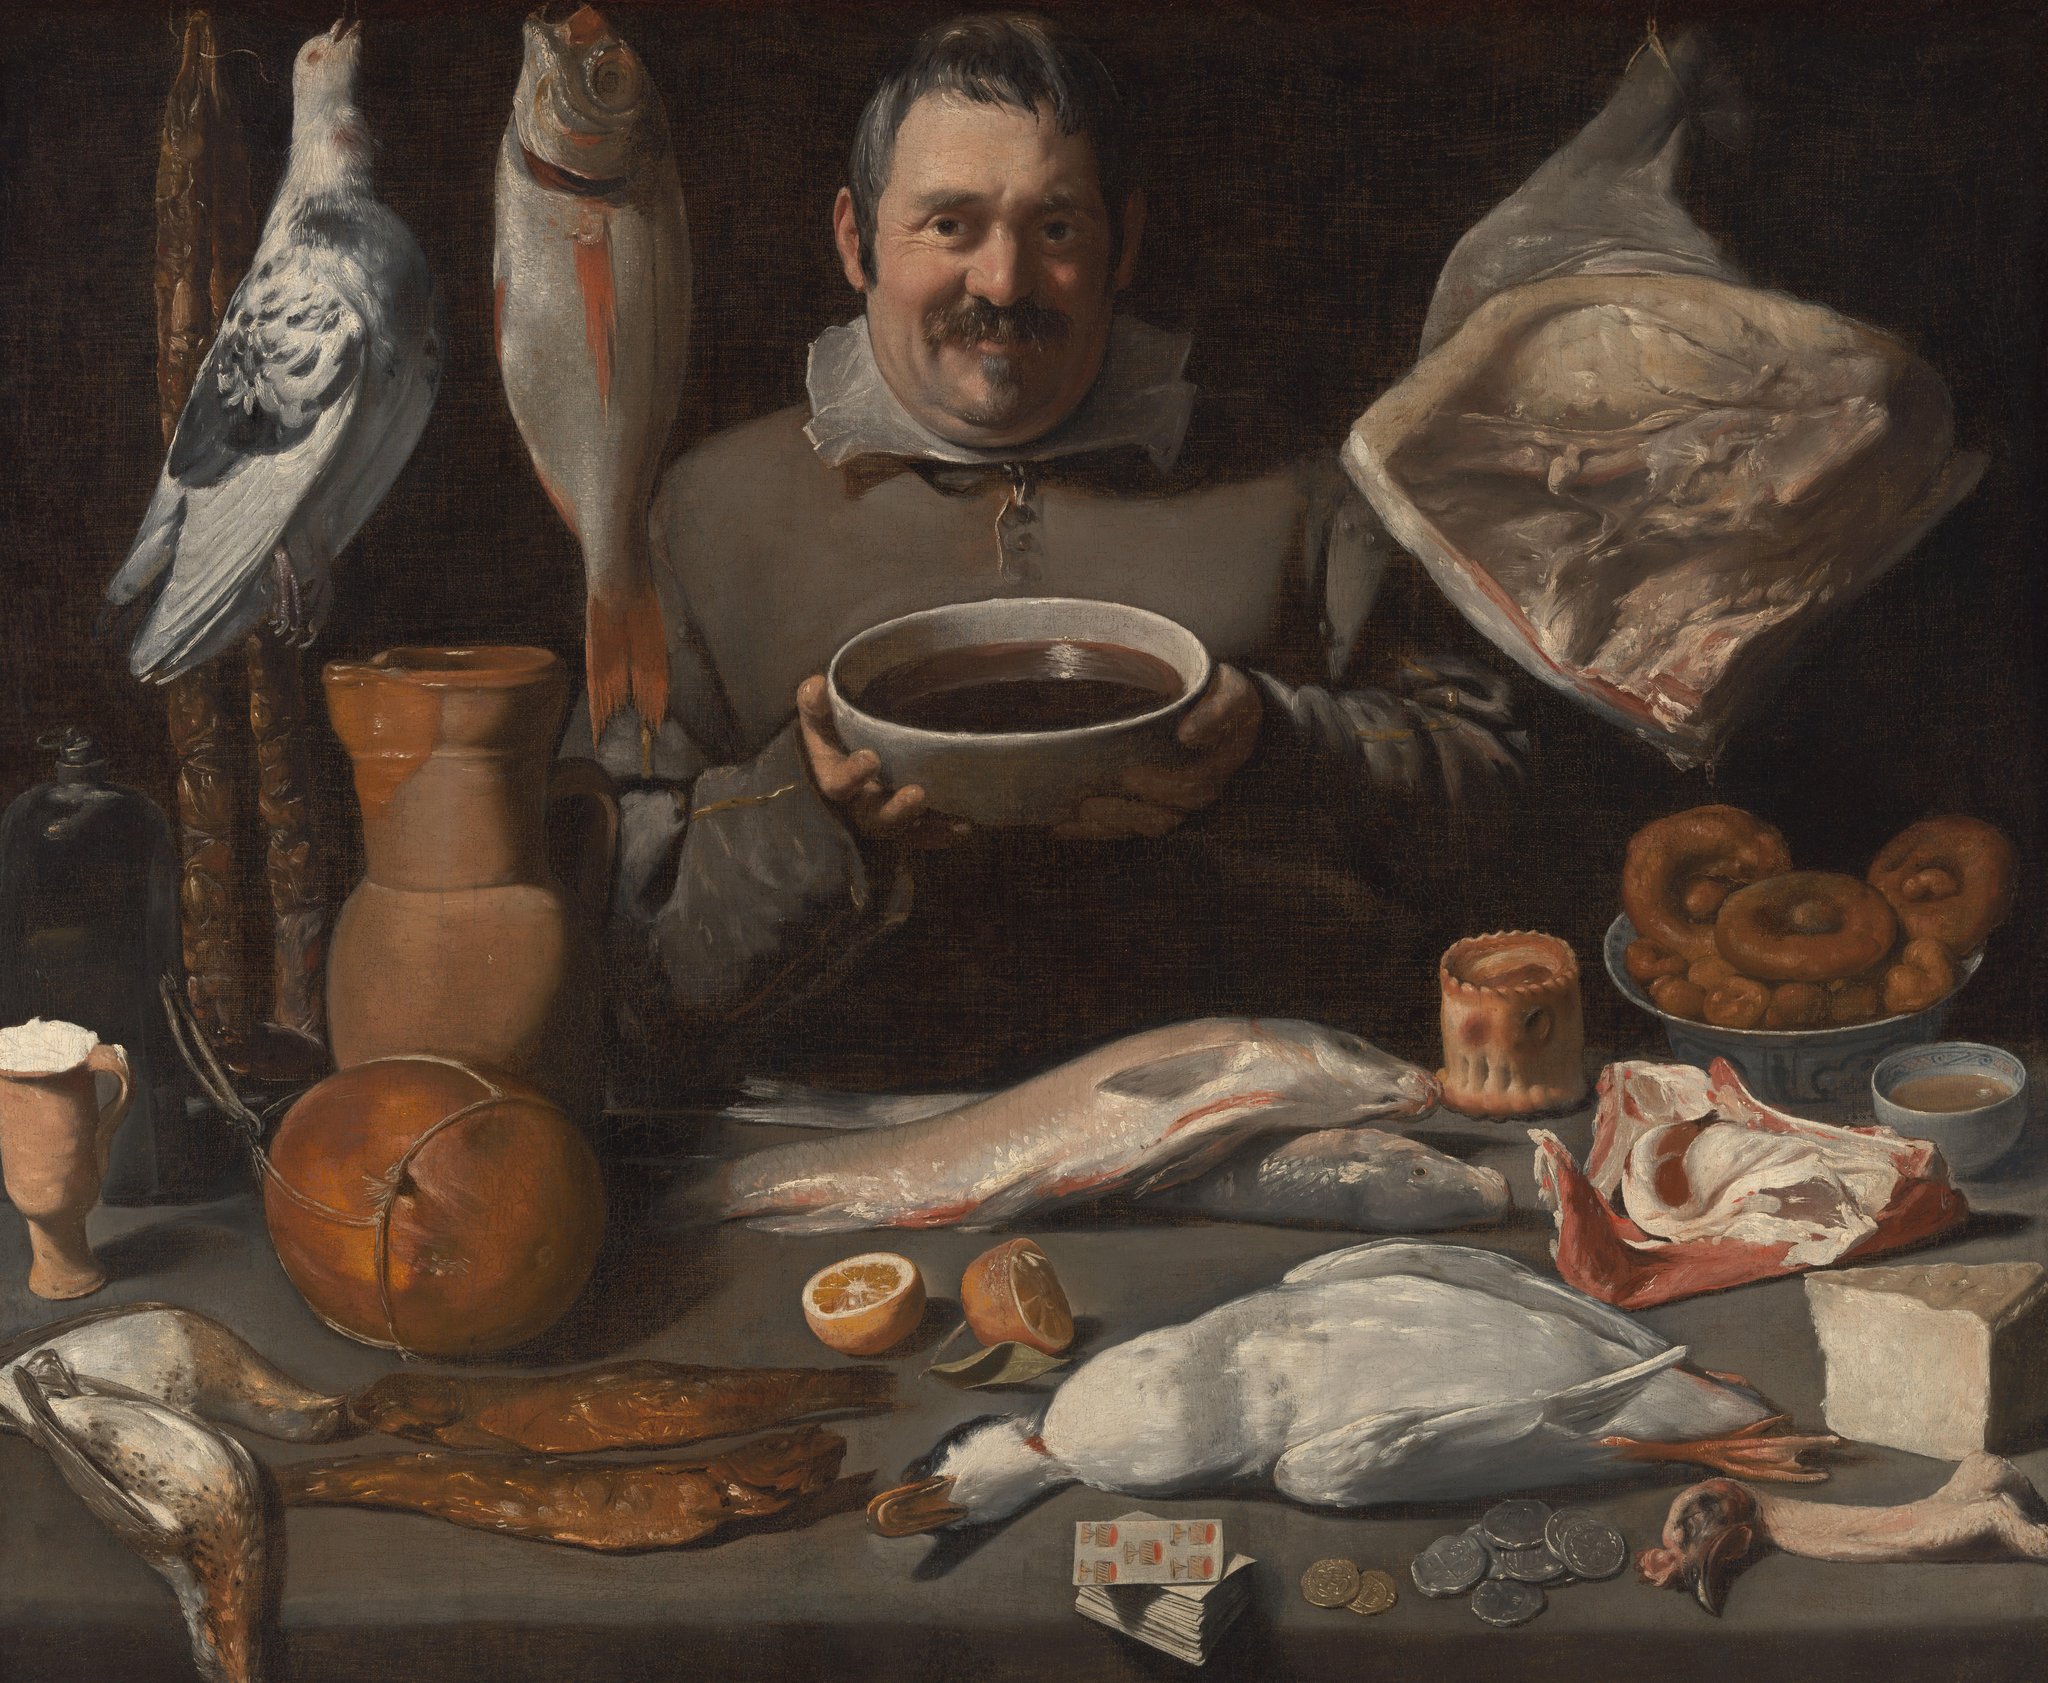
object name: painting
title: Kitchen Scene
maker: meester van de amsterdamse bodegón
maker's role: painter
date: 1610-1625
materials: canvas, oil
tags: foodstuffs; still life of foodstuffs, kitchen-interior with foodstuffs in foreground (dutch: 'keukenstuk')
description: The appreciation of everyday objects was reinforced by the ever-increasing role that realism began to play in 17th-century art. Glass, porcelain, silver, the texture of fruit, dead animals, hanging or lying on a table: all of these elements were readily found in domestic surroundings and represented a veritable challenge by means of which painters could convince the public of their artistic merits.